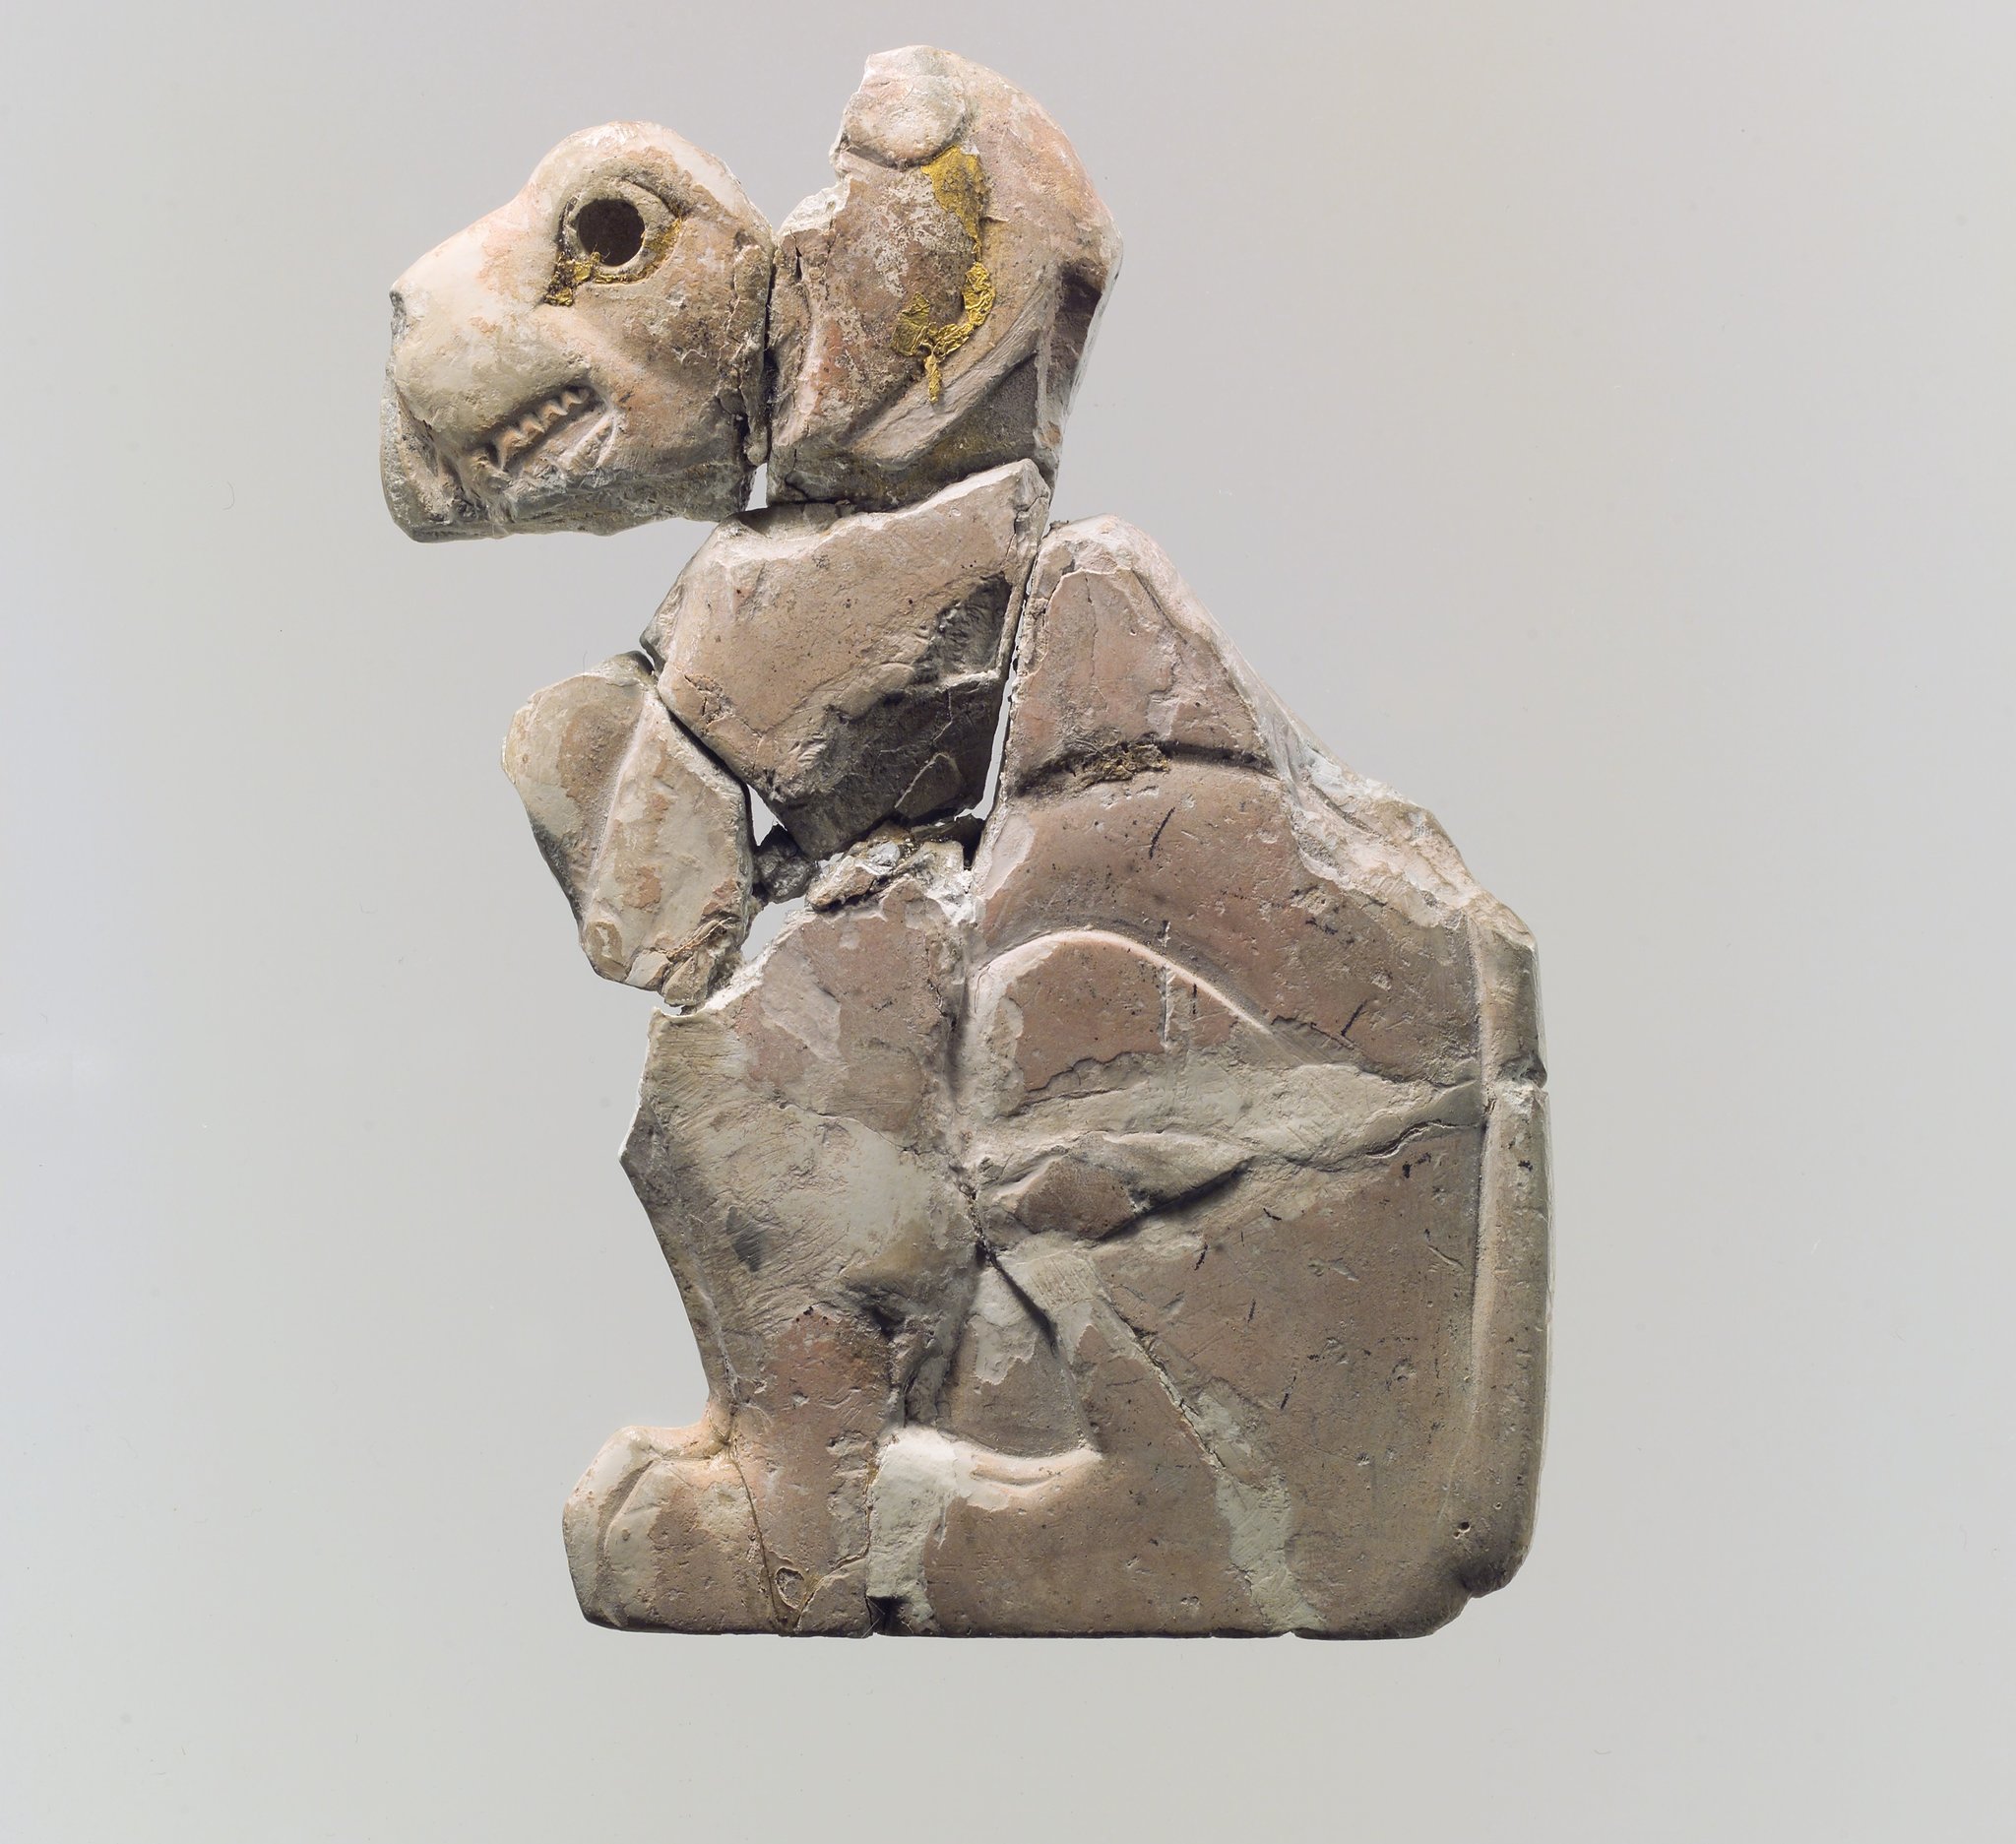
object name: furniture element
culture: assyrian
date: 1800-1701 BCE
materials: gold foil, ivory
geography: anatolia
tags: animals